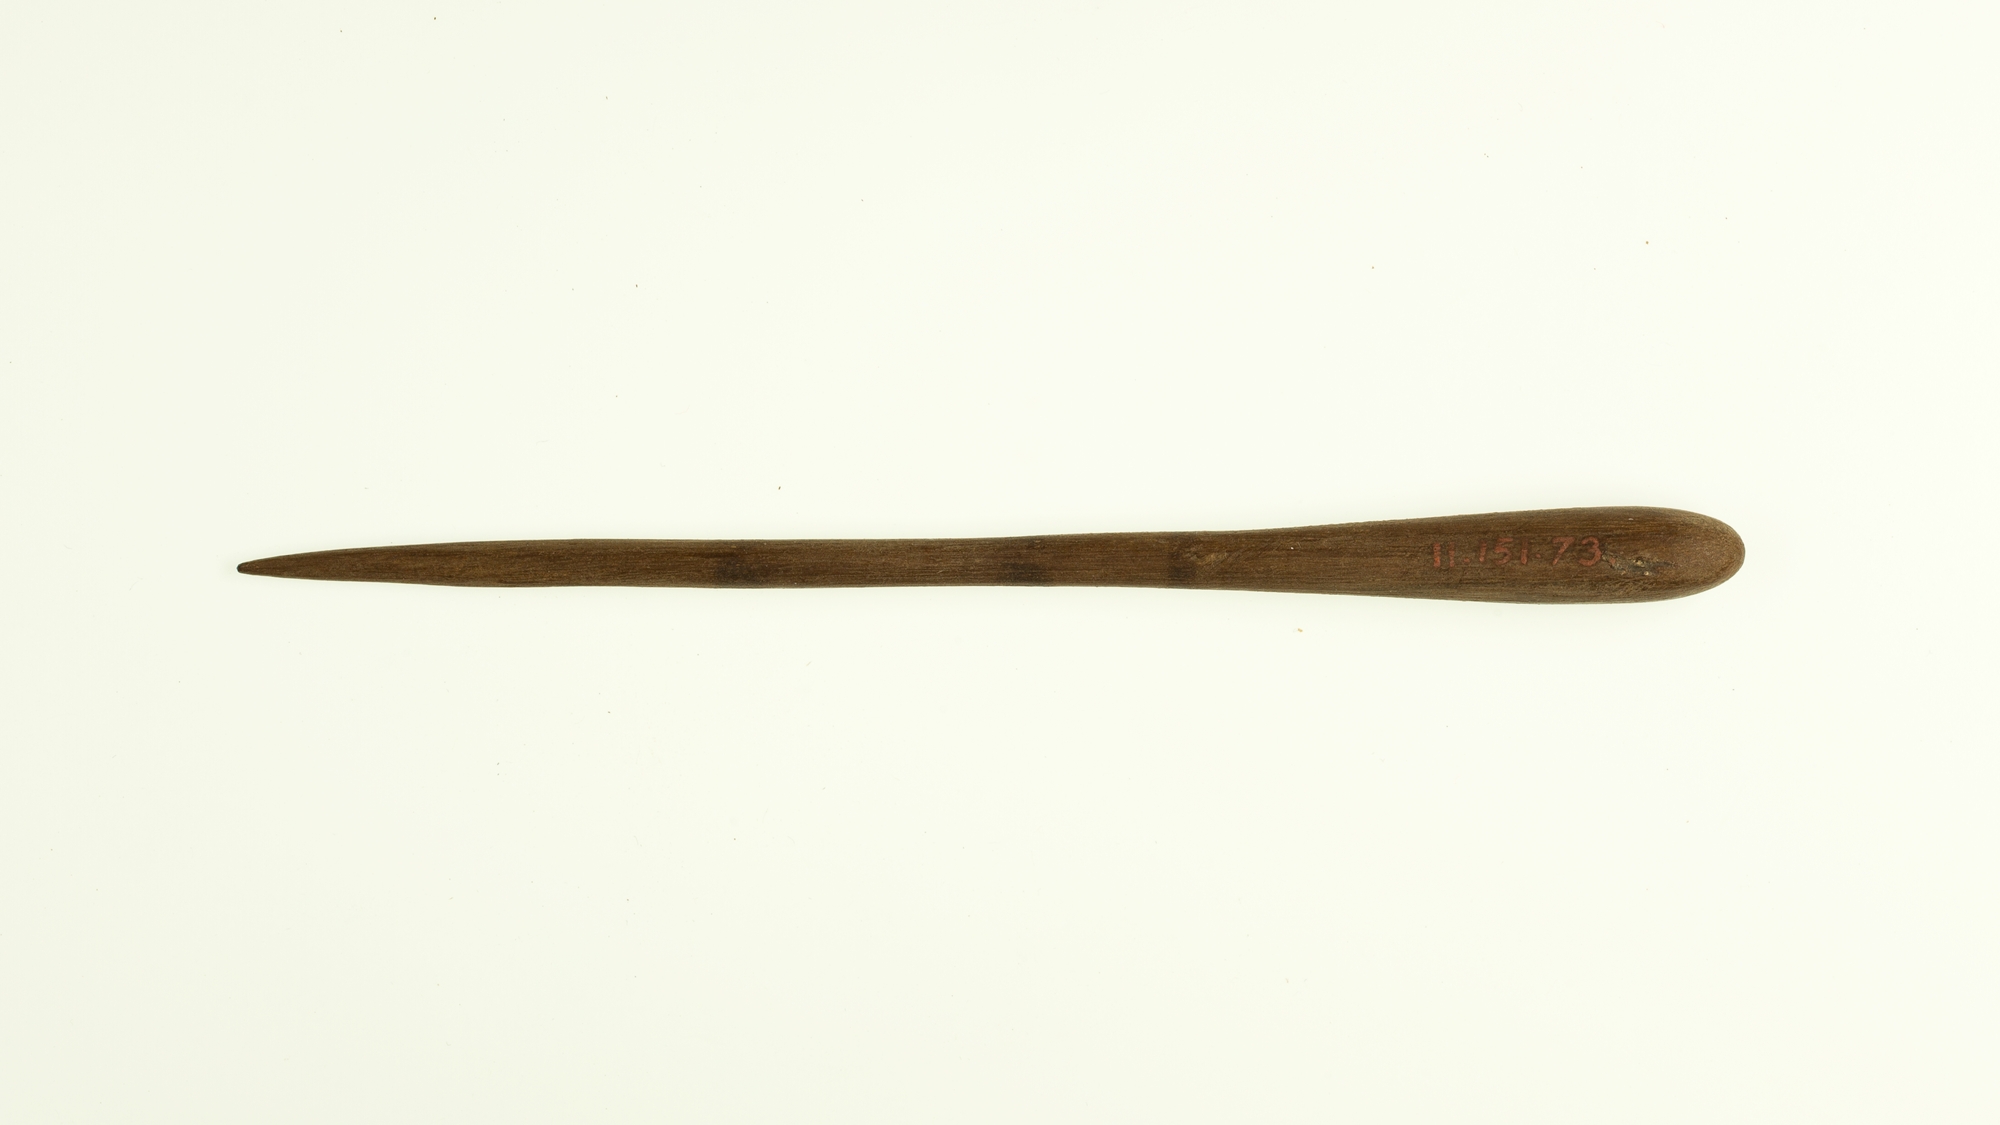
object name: kohl stick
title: Kohl stick (?)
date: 1295-1070 BCE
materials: wood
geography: egypt